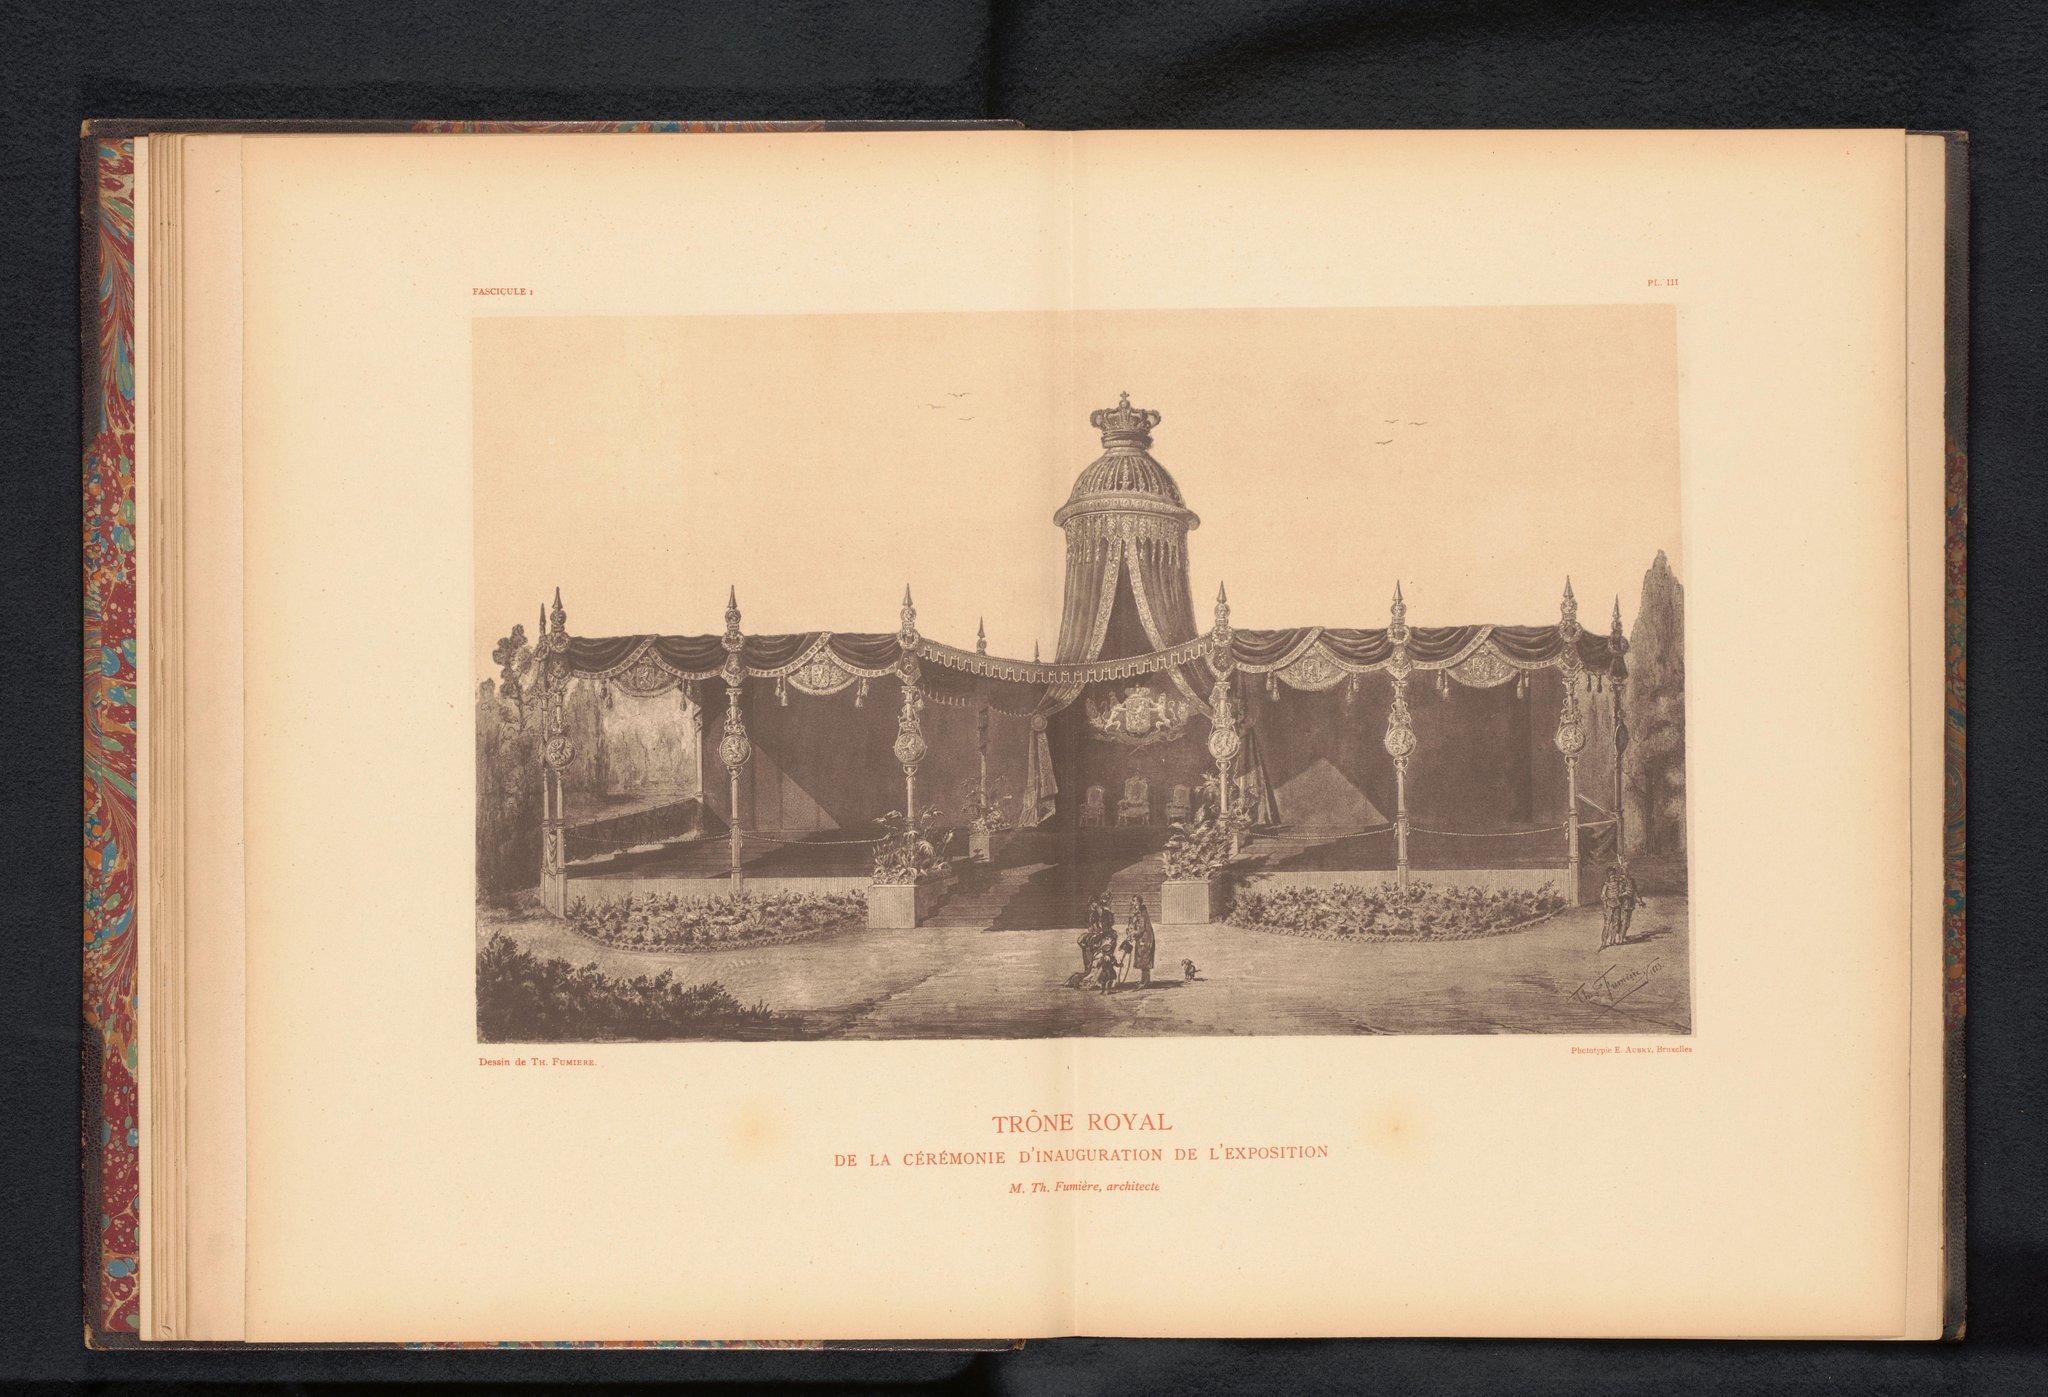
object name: reproduction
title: Trône Royal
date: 1878-1883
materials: paper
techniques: photograph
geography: brussels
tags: world fair, world exhibition, throne, amsterdam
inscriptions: inscription: ‘Fascicule I/ PL. III’